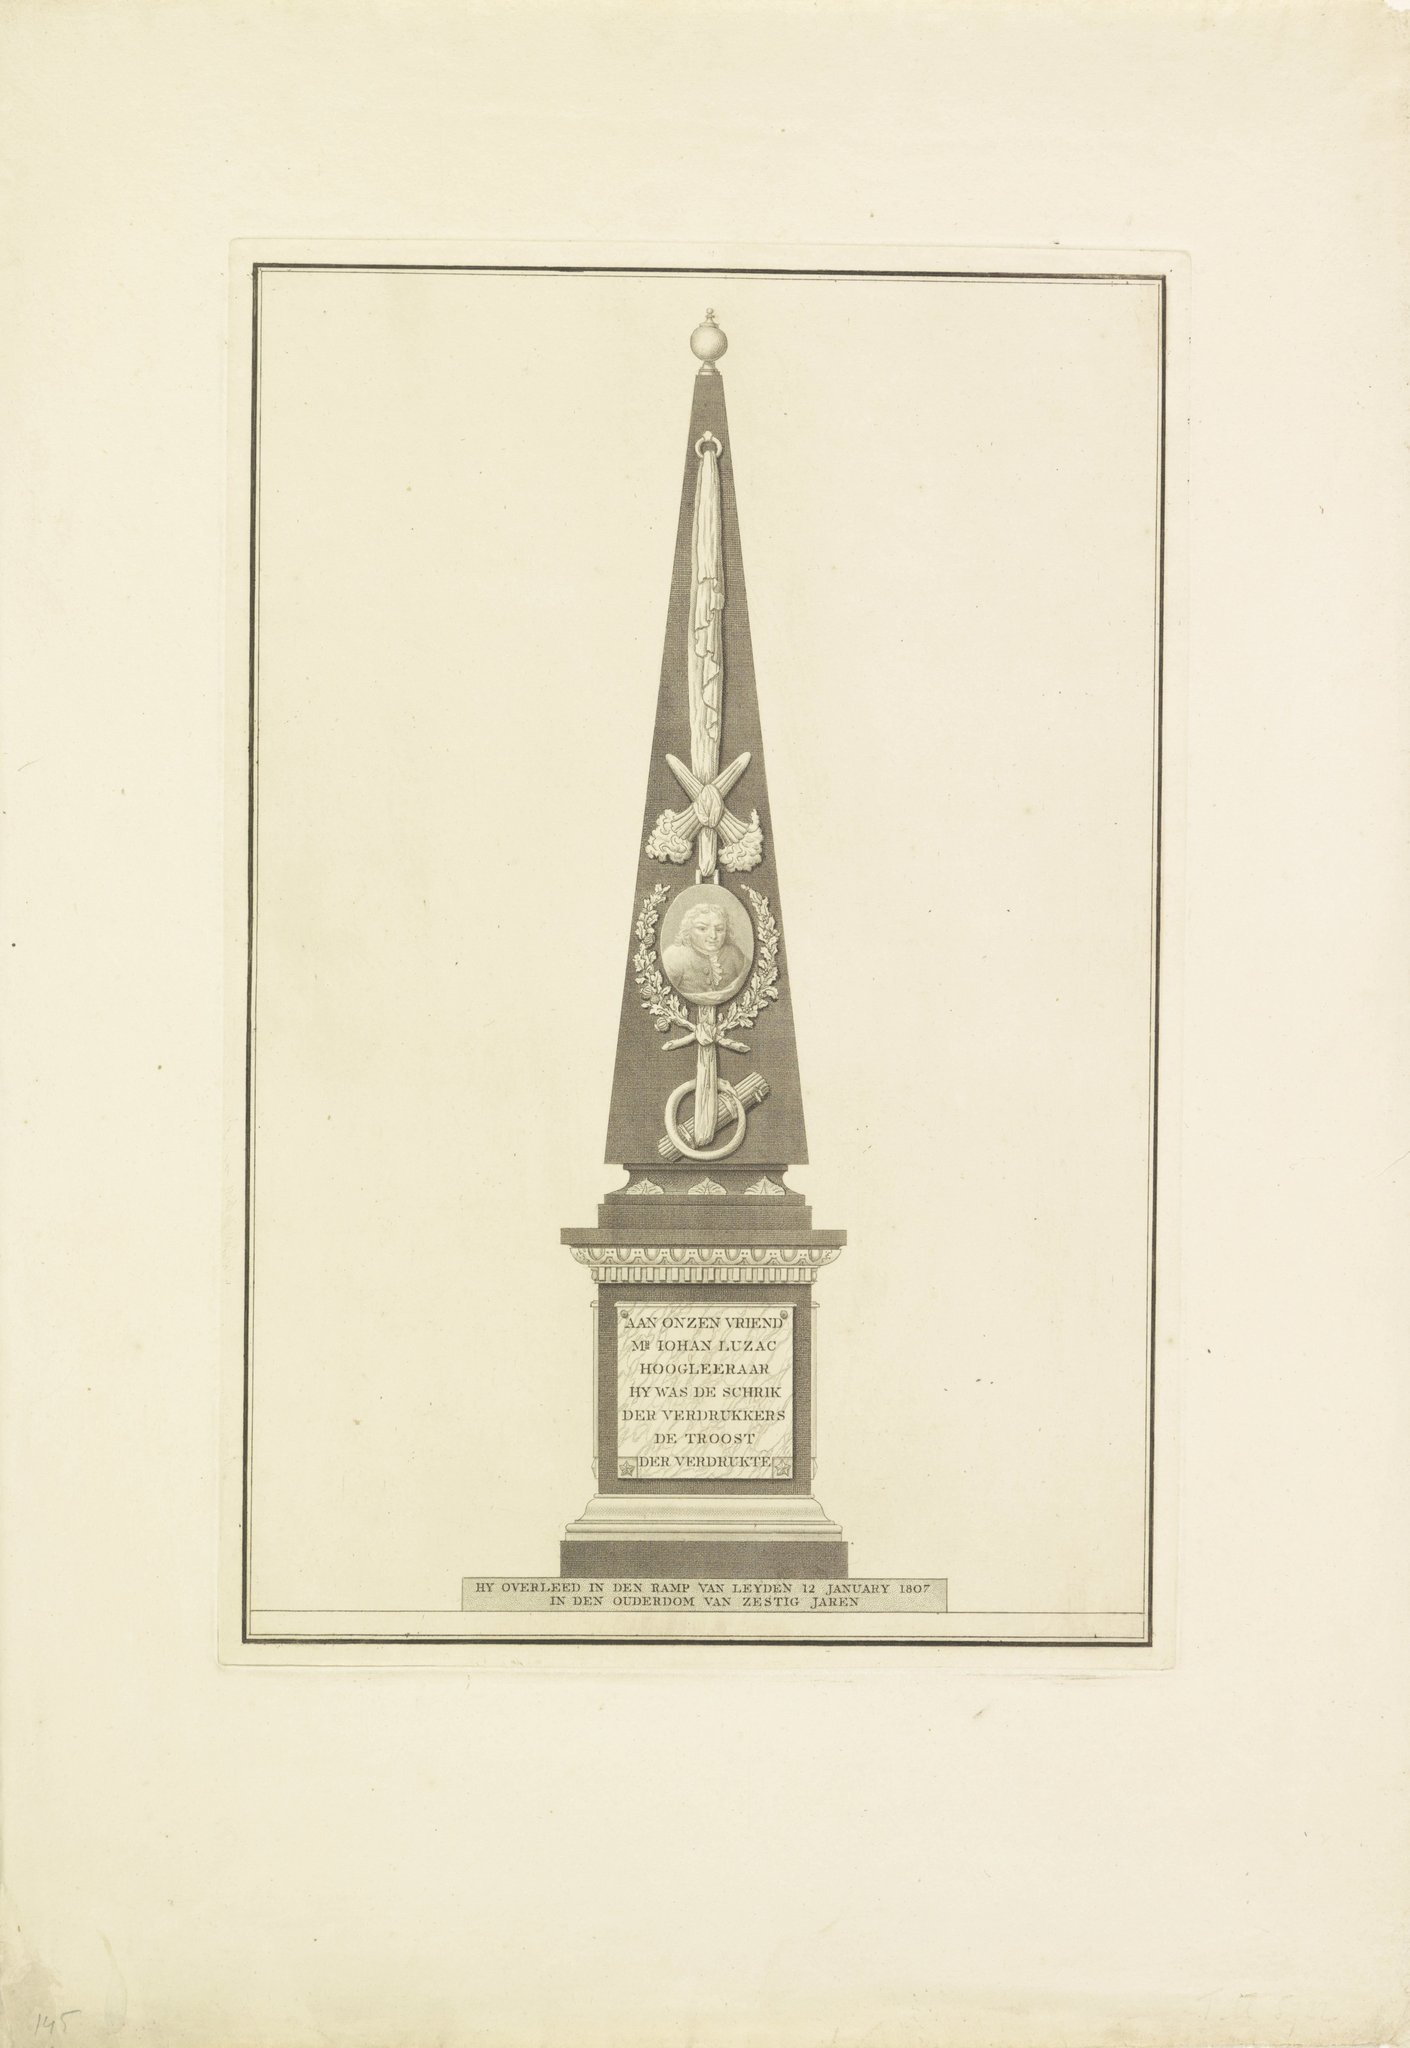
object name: print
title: Gedenkzuil voor Jean Luzac, 1807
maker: Anonymous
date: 1807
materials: paper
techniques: etching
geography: netherlands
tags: grave, tomb, leiden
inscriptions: collector's mark: Lugt 2228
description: Gedenkzuil opgericht in de Pieterskerk voor Jean Luzac, omgekomen bij de Leidse buskruitramp van 12 januari 1807.